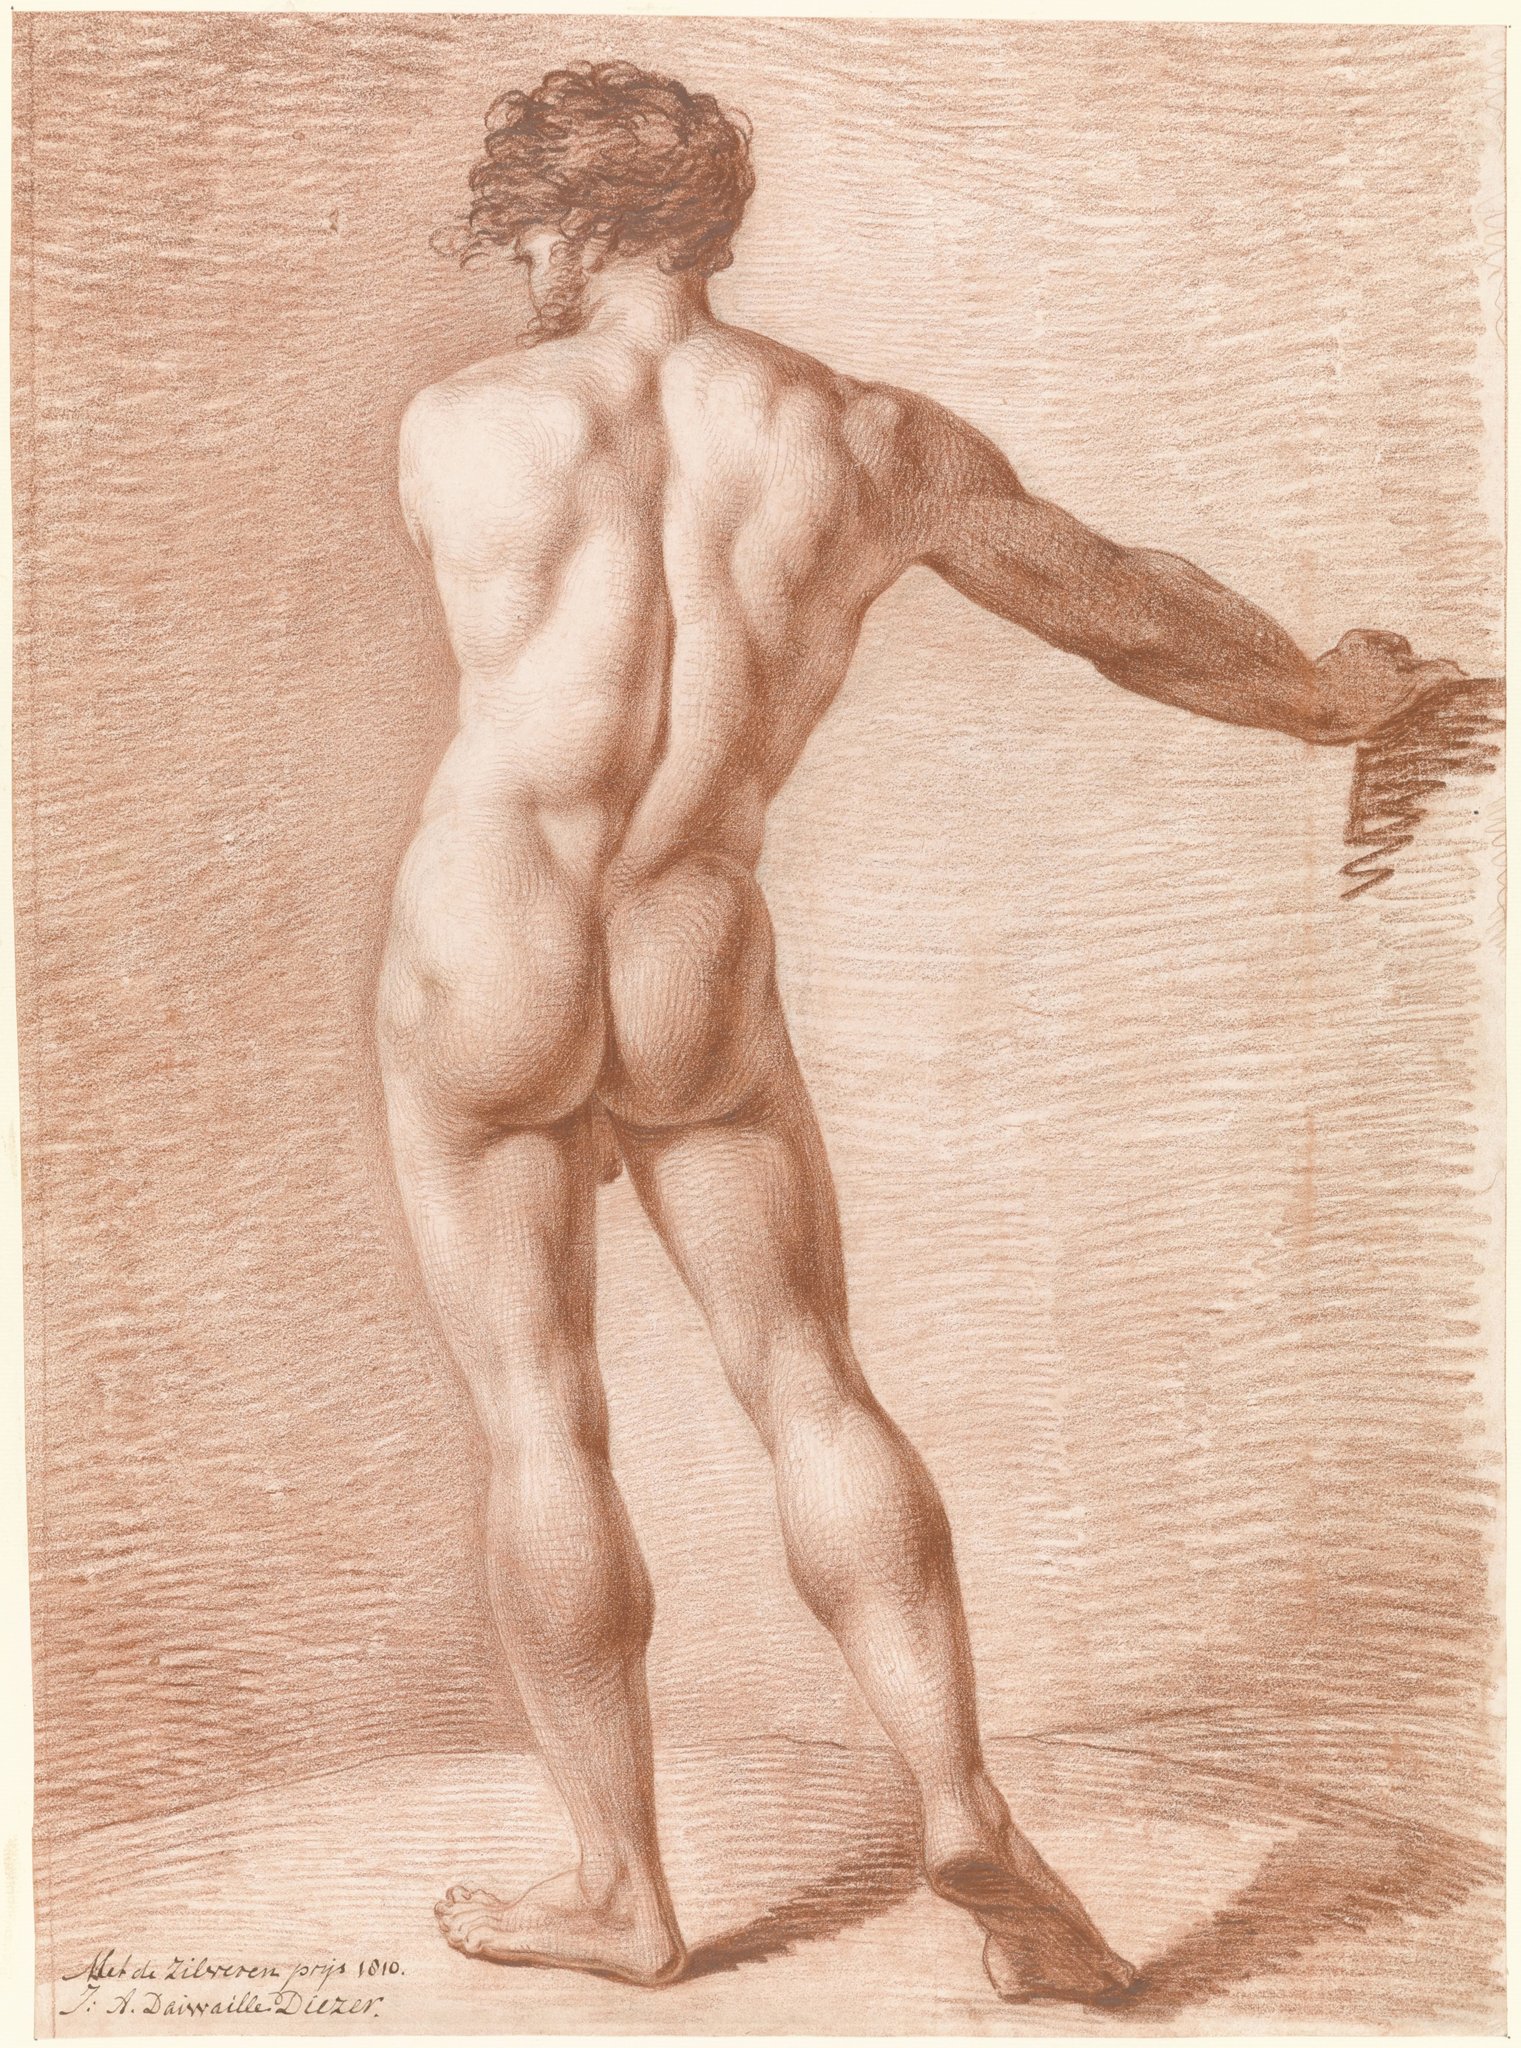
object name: drawing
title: Figuurstudie van staand naakt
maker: jean augustin daiwaille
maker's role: draughtsman, print maker, printer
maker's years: 1786-1850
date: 1810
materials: chalk, paper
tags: standing figure (+ nude human being)